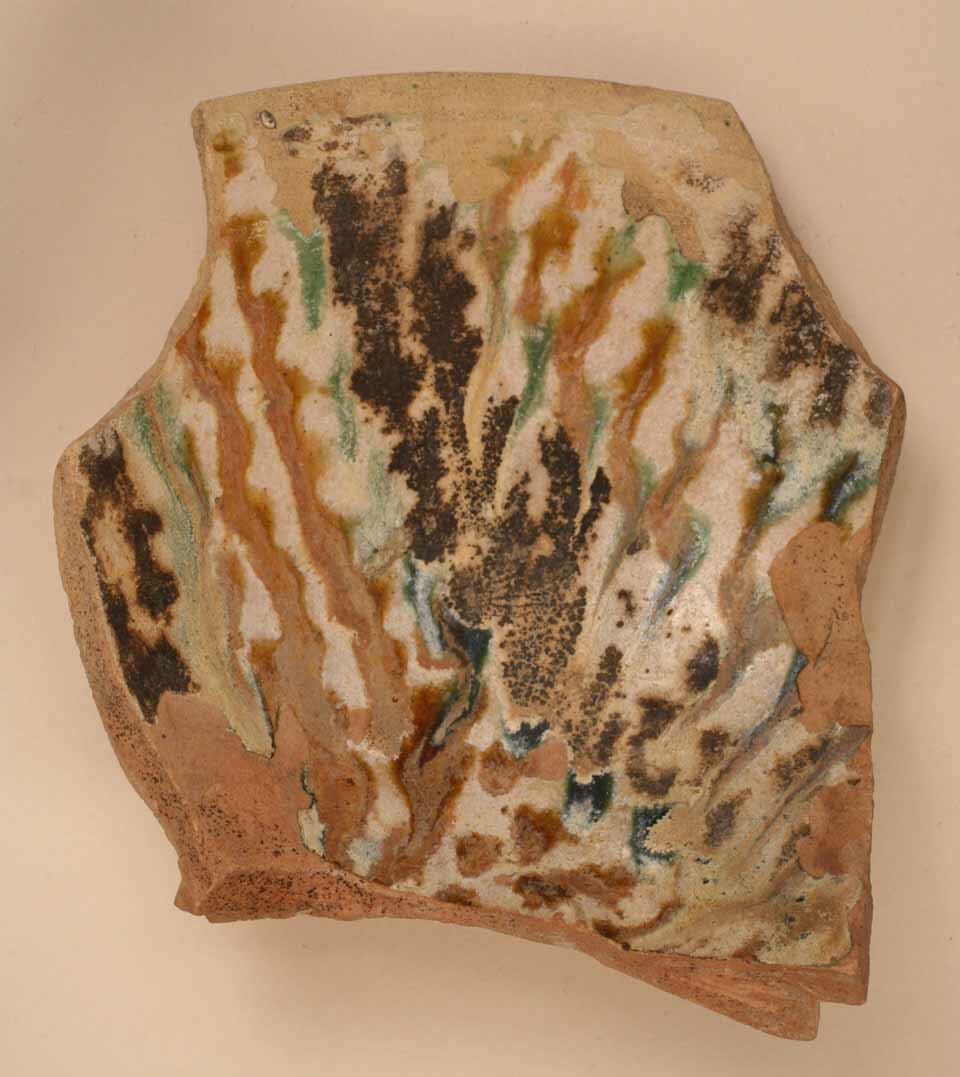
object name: fragment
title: Ceramic Fragment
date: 701-900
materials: earthenware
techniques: glazing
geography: iraq